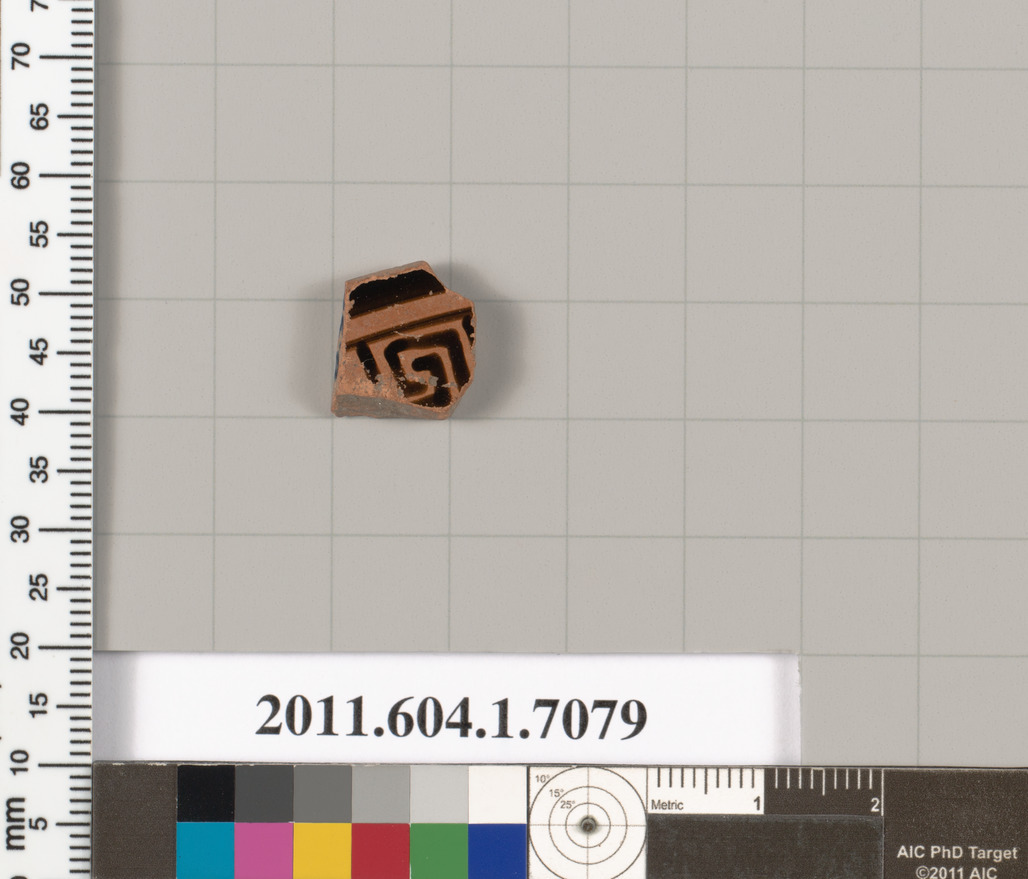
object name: kylix fragment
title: Terracotta fragment of a kylix (drinking cup)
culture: greek, attic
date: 500-480 BCE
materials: terracotta